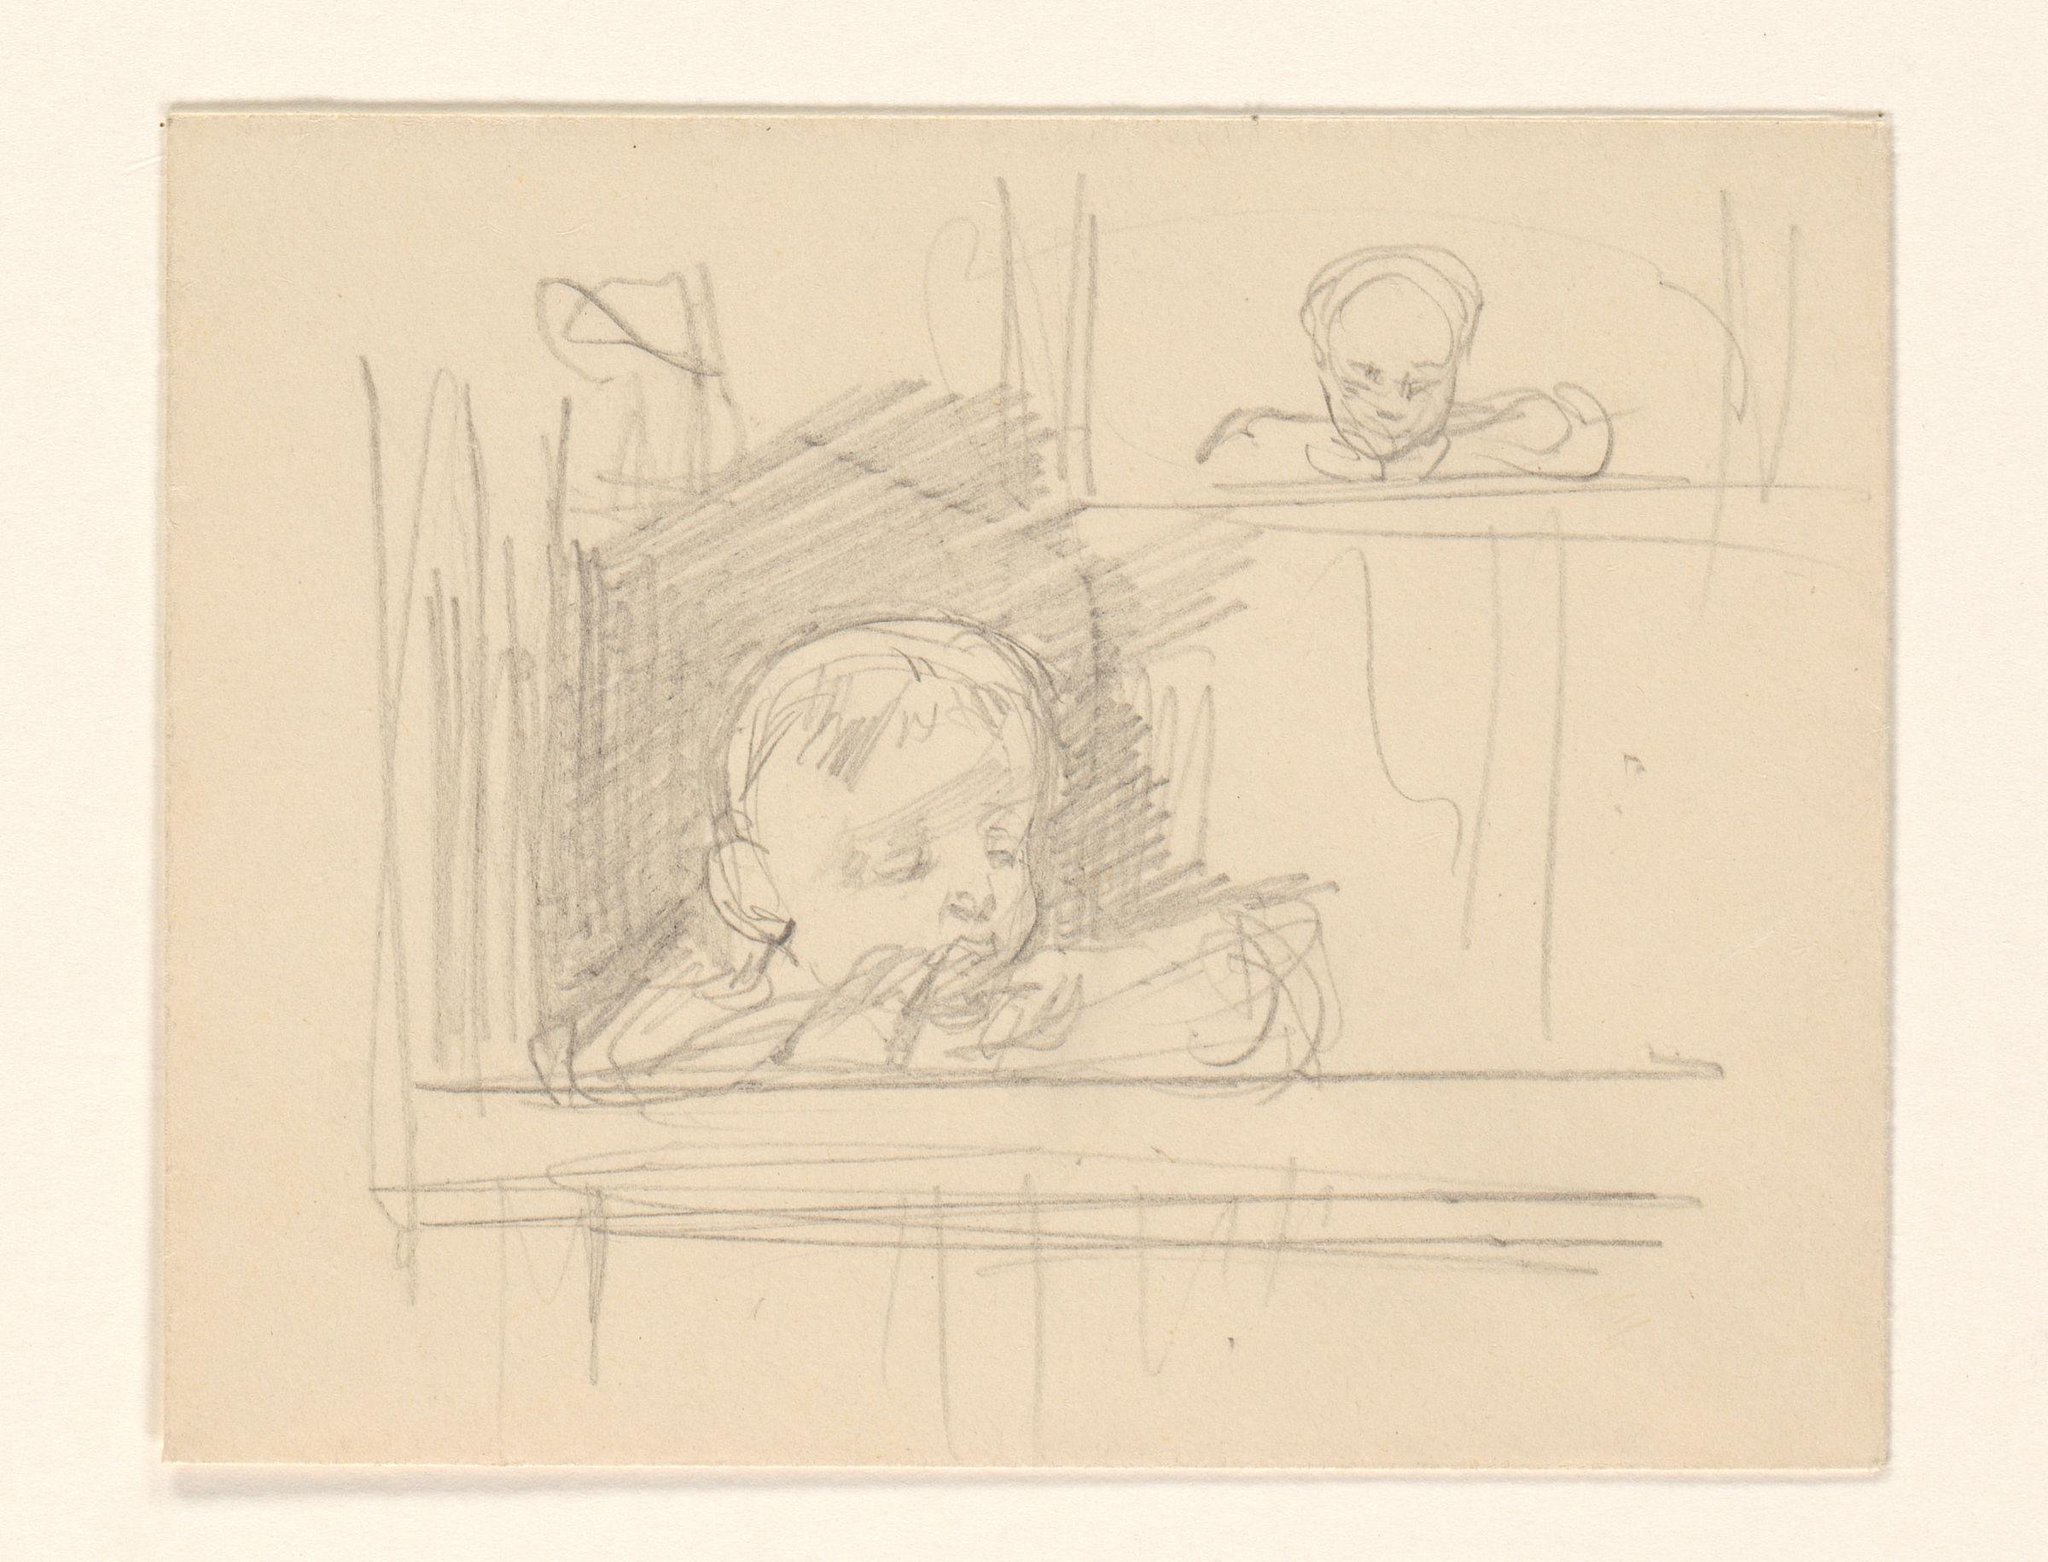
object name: drawing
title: Schets van een kind, dat uit een raam kijkt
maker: august allebé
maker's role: draughtsman, print maker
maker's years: 1838-1927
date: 1848-1927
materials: paper, pencil